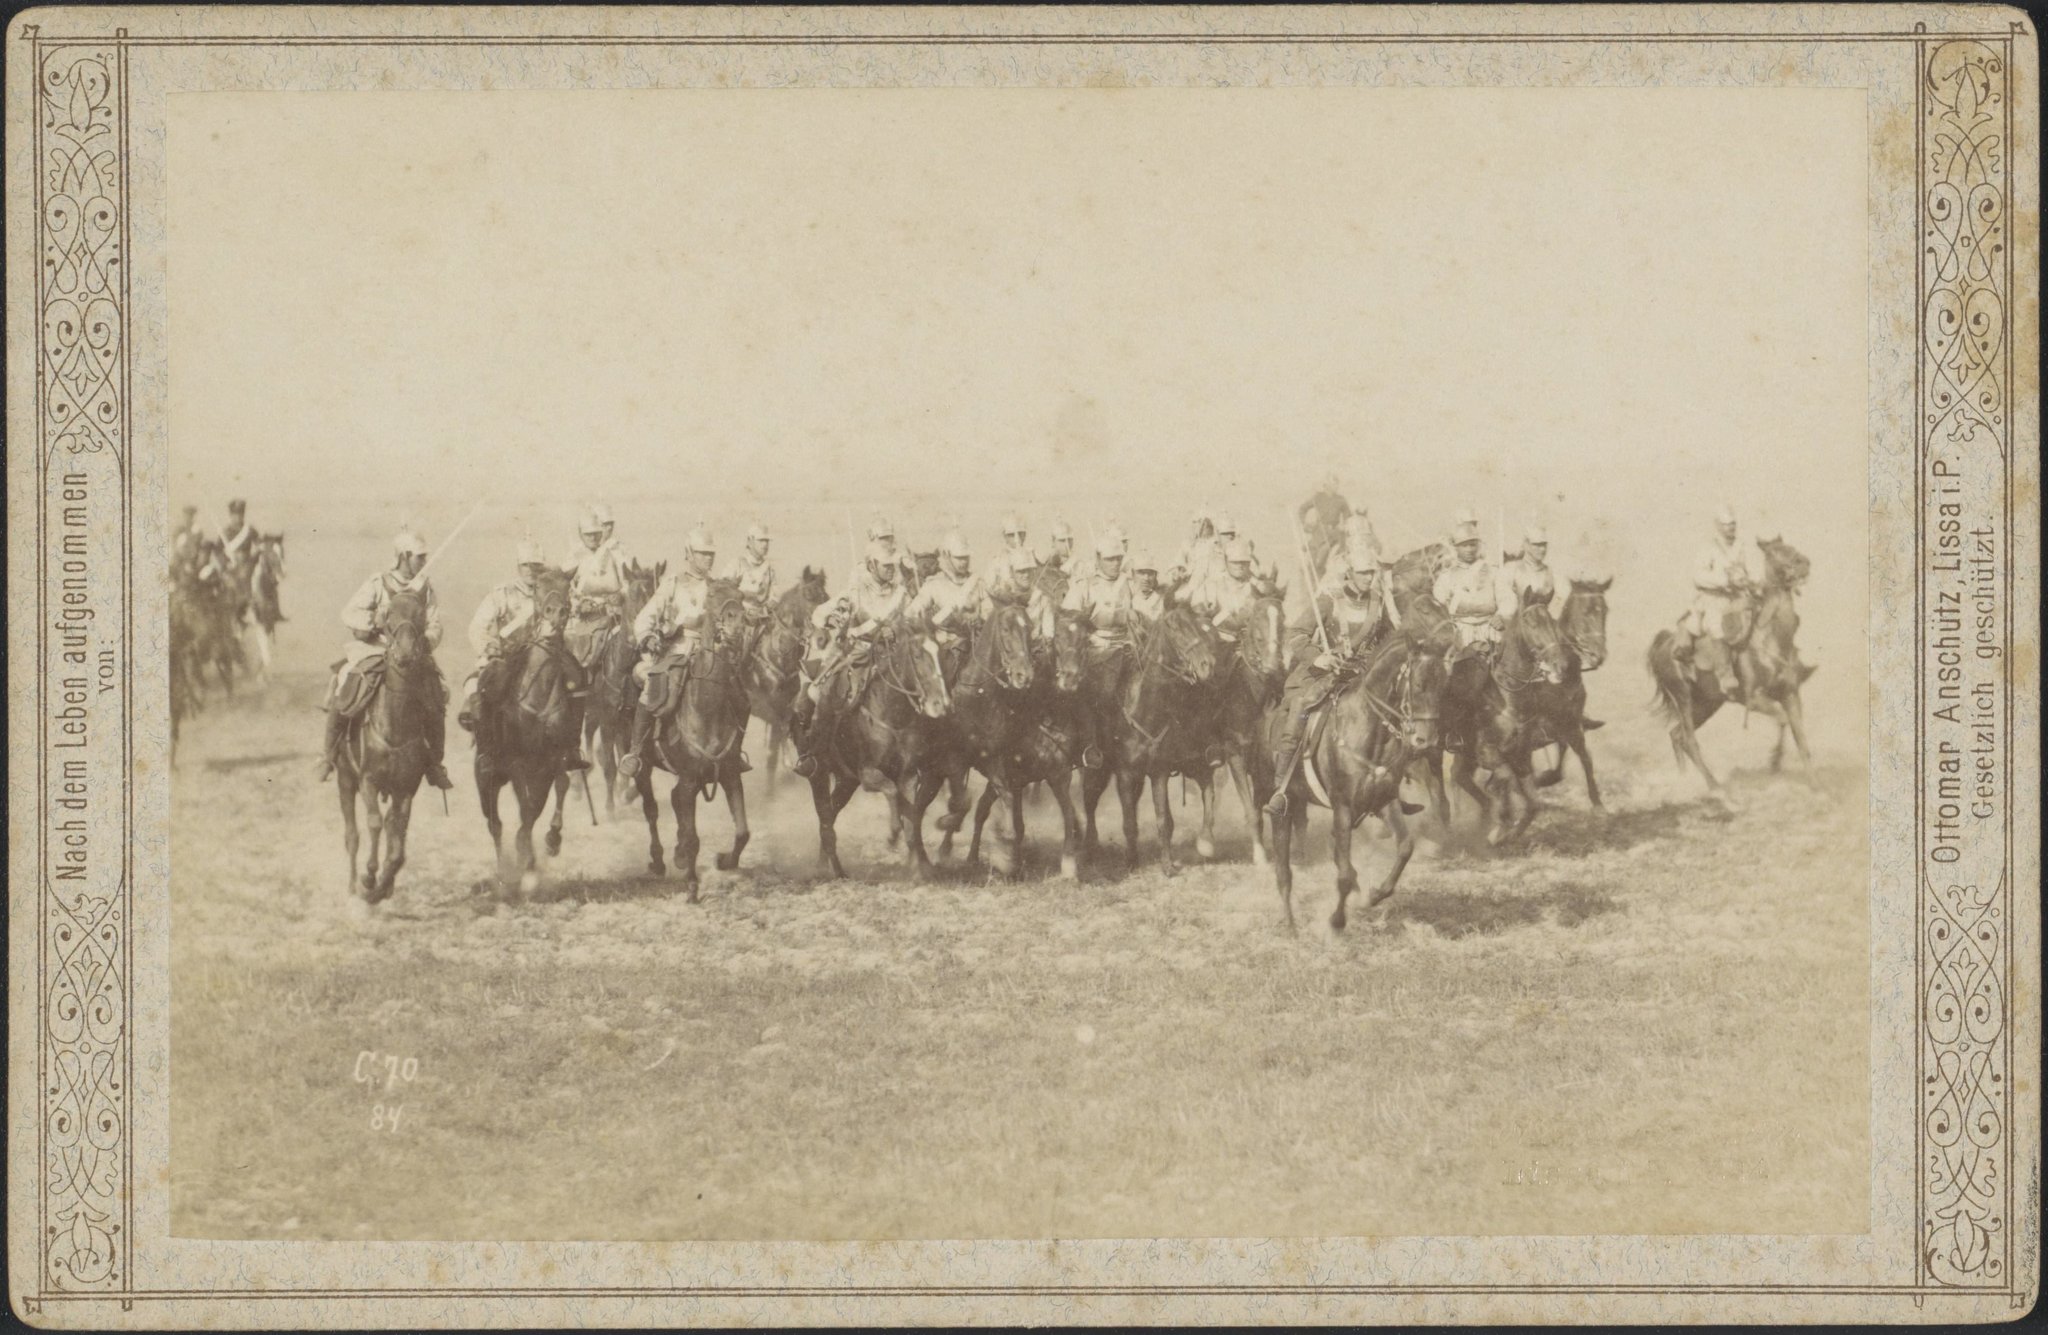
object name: cabinet photograph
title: Cavalerie op de heide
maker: ottomar anschütz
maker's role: fotograaf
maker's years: 1846-1907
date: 1884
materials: cardboard, paper, photographic support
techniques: albumen print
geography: germany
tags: land forces (+ cavalry, horsemen), historical persons, germany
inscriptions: check stamp: ‘Ottomar Anschütz Lissa i.P. 1884’, negative number: ‘C.70 84’